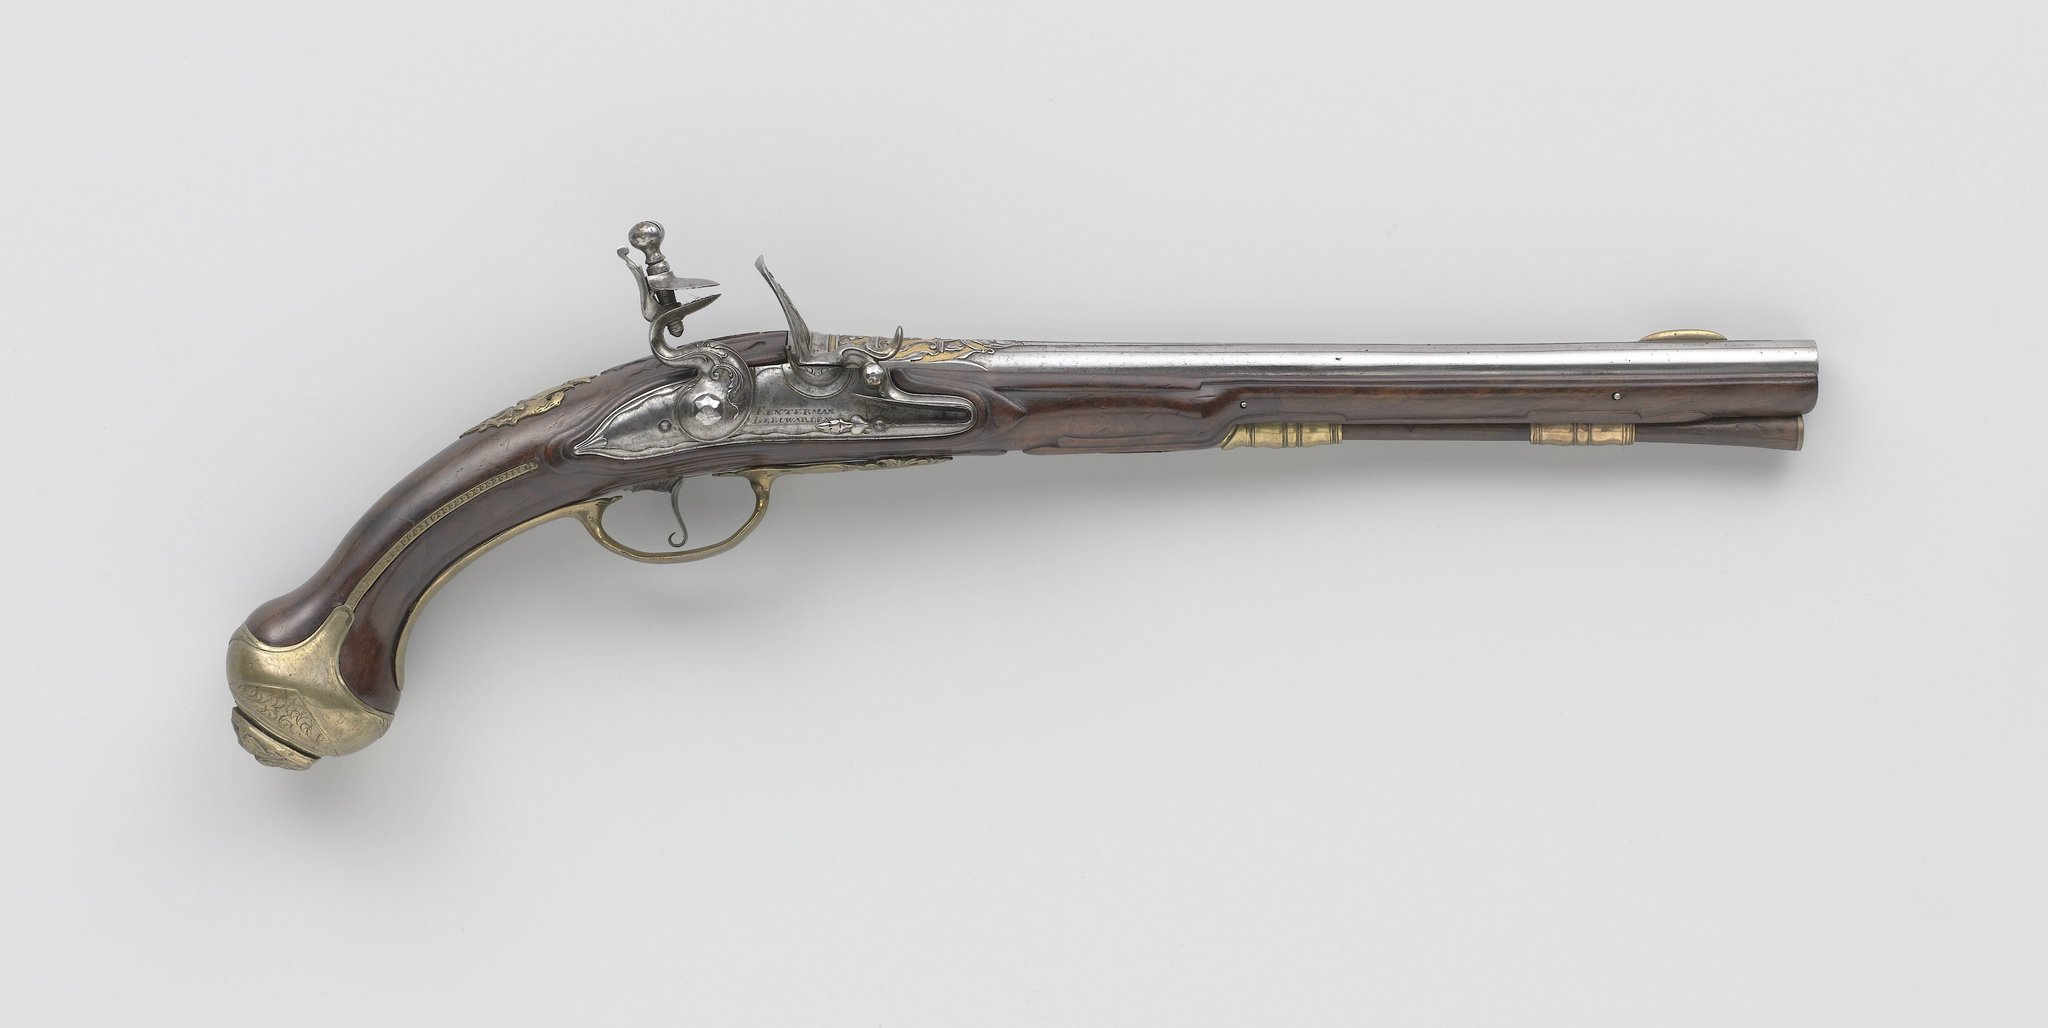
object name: flintlock pistol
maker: gerrit de oude penterman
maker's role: geweermaker, pistoolmaker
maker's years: -1727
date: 1695-1700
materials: brass, wood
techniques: metalworking, cutting, engraving, faceting, gilding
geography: leeuwarden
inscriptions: signature: ‘PENTERMAN // LEEUWARDEN’, inscription: ‘PENTERMAN’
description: The Pentermans were a family of gunmakers who played a leading role in firearms production in both Utrecht and Leeuwarden. An unusual feature of this pistol are its hidden screws. To disassemble the weapon, the rounded mask on the butt cap must be removed, as this conceals the first screw.